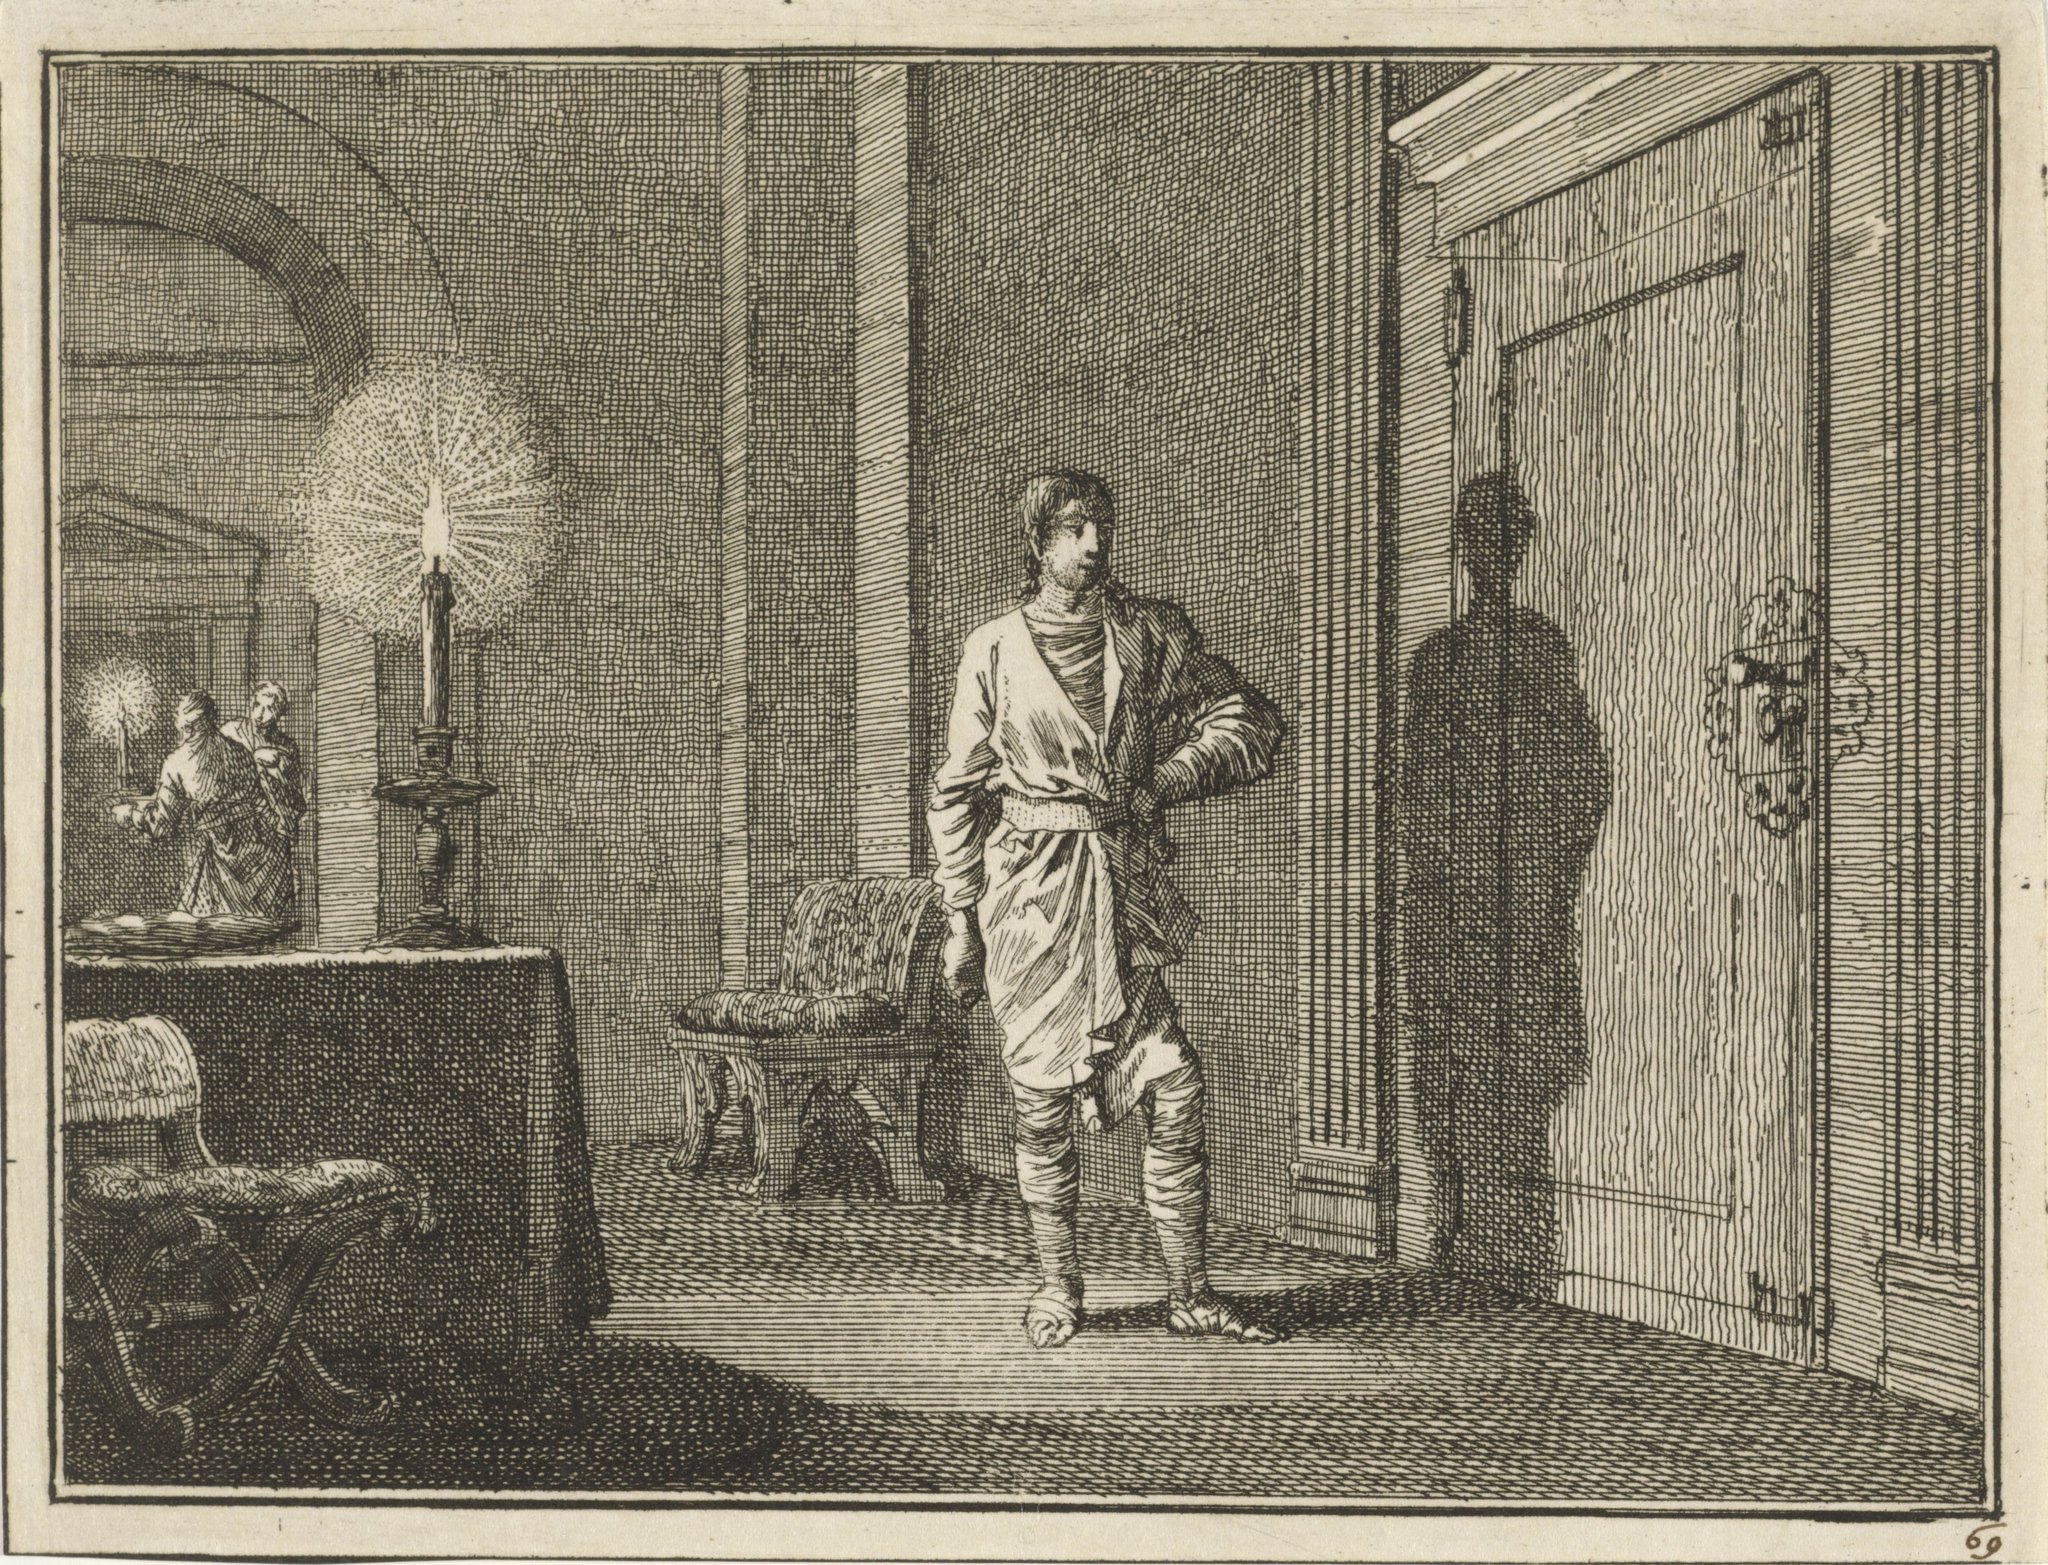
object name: print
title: Gelijkenis van de dienstknecht die ´s nachts op zijn heer staat te wachten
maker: jan luyken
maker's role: draughtsman, print maker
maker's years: 1649-1712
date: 1712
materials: paper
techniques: etching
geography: amsterdam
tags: parables and proverbial sayings of christ ~ the relationship master - servant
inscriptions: number: ‘69’, collector's mark: Lugt 2228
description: Proefdruk van illustratie uit: Luyken, Jan. De schriftuurlyke geschiedenissen en gelykenissen van het Oude en Nieuwe Verbond, 2 delen. Amsterdam: Wed. Pieter Arentsz II en Cornelis van der Sys, 1712, dl. II.